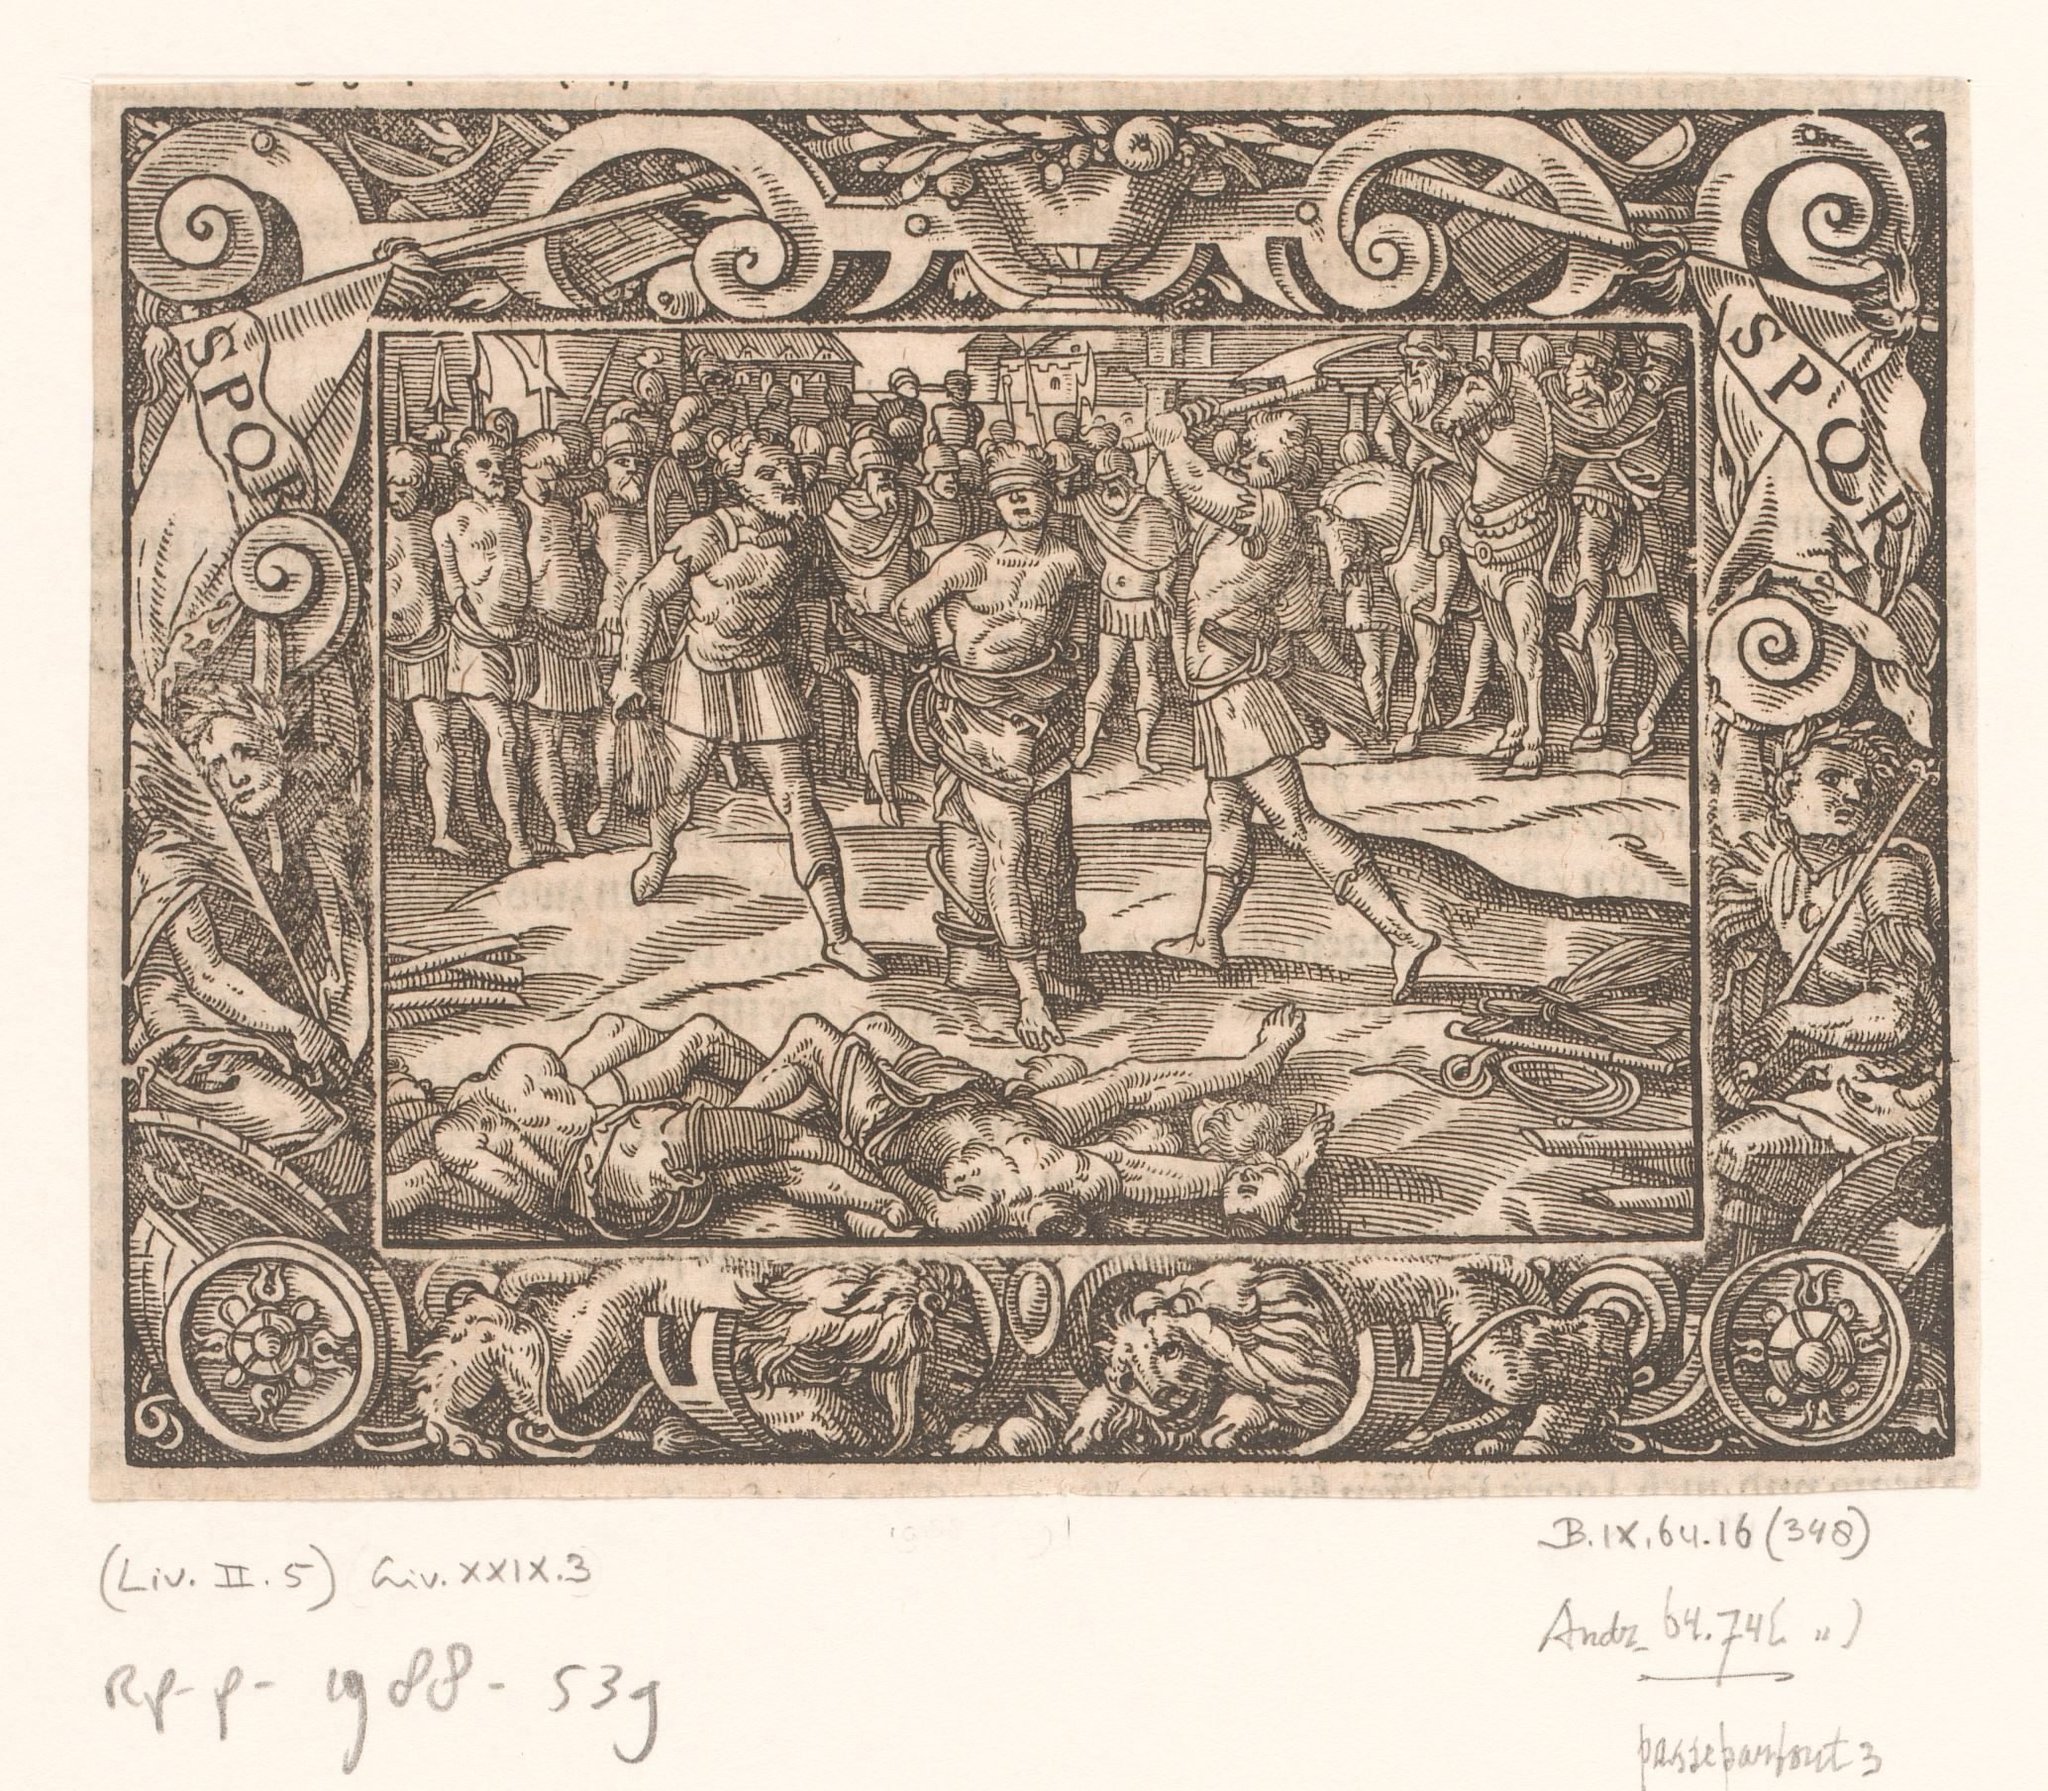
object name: print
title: Historische gebeurtenissen uit het Romeinse rijk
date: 1574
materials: paper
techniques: woodcut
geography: straatsburg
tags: l. junius brutus has his two sons beheaded because they joined a conspiracy, historical events and situations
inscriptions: collector's mark: Lugt 2228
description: Omlijsting en voorstelling van verschillende blokken gedrukt. Prent voor het eerst gebruikt in: Livius, Titus. Von Ankunft und Ursprung des Römischen Reichs. Straatsburg: Theodosius Rihel, 1574.